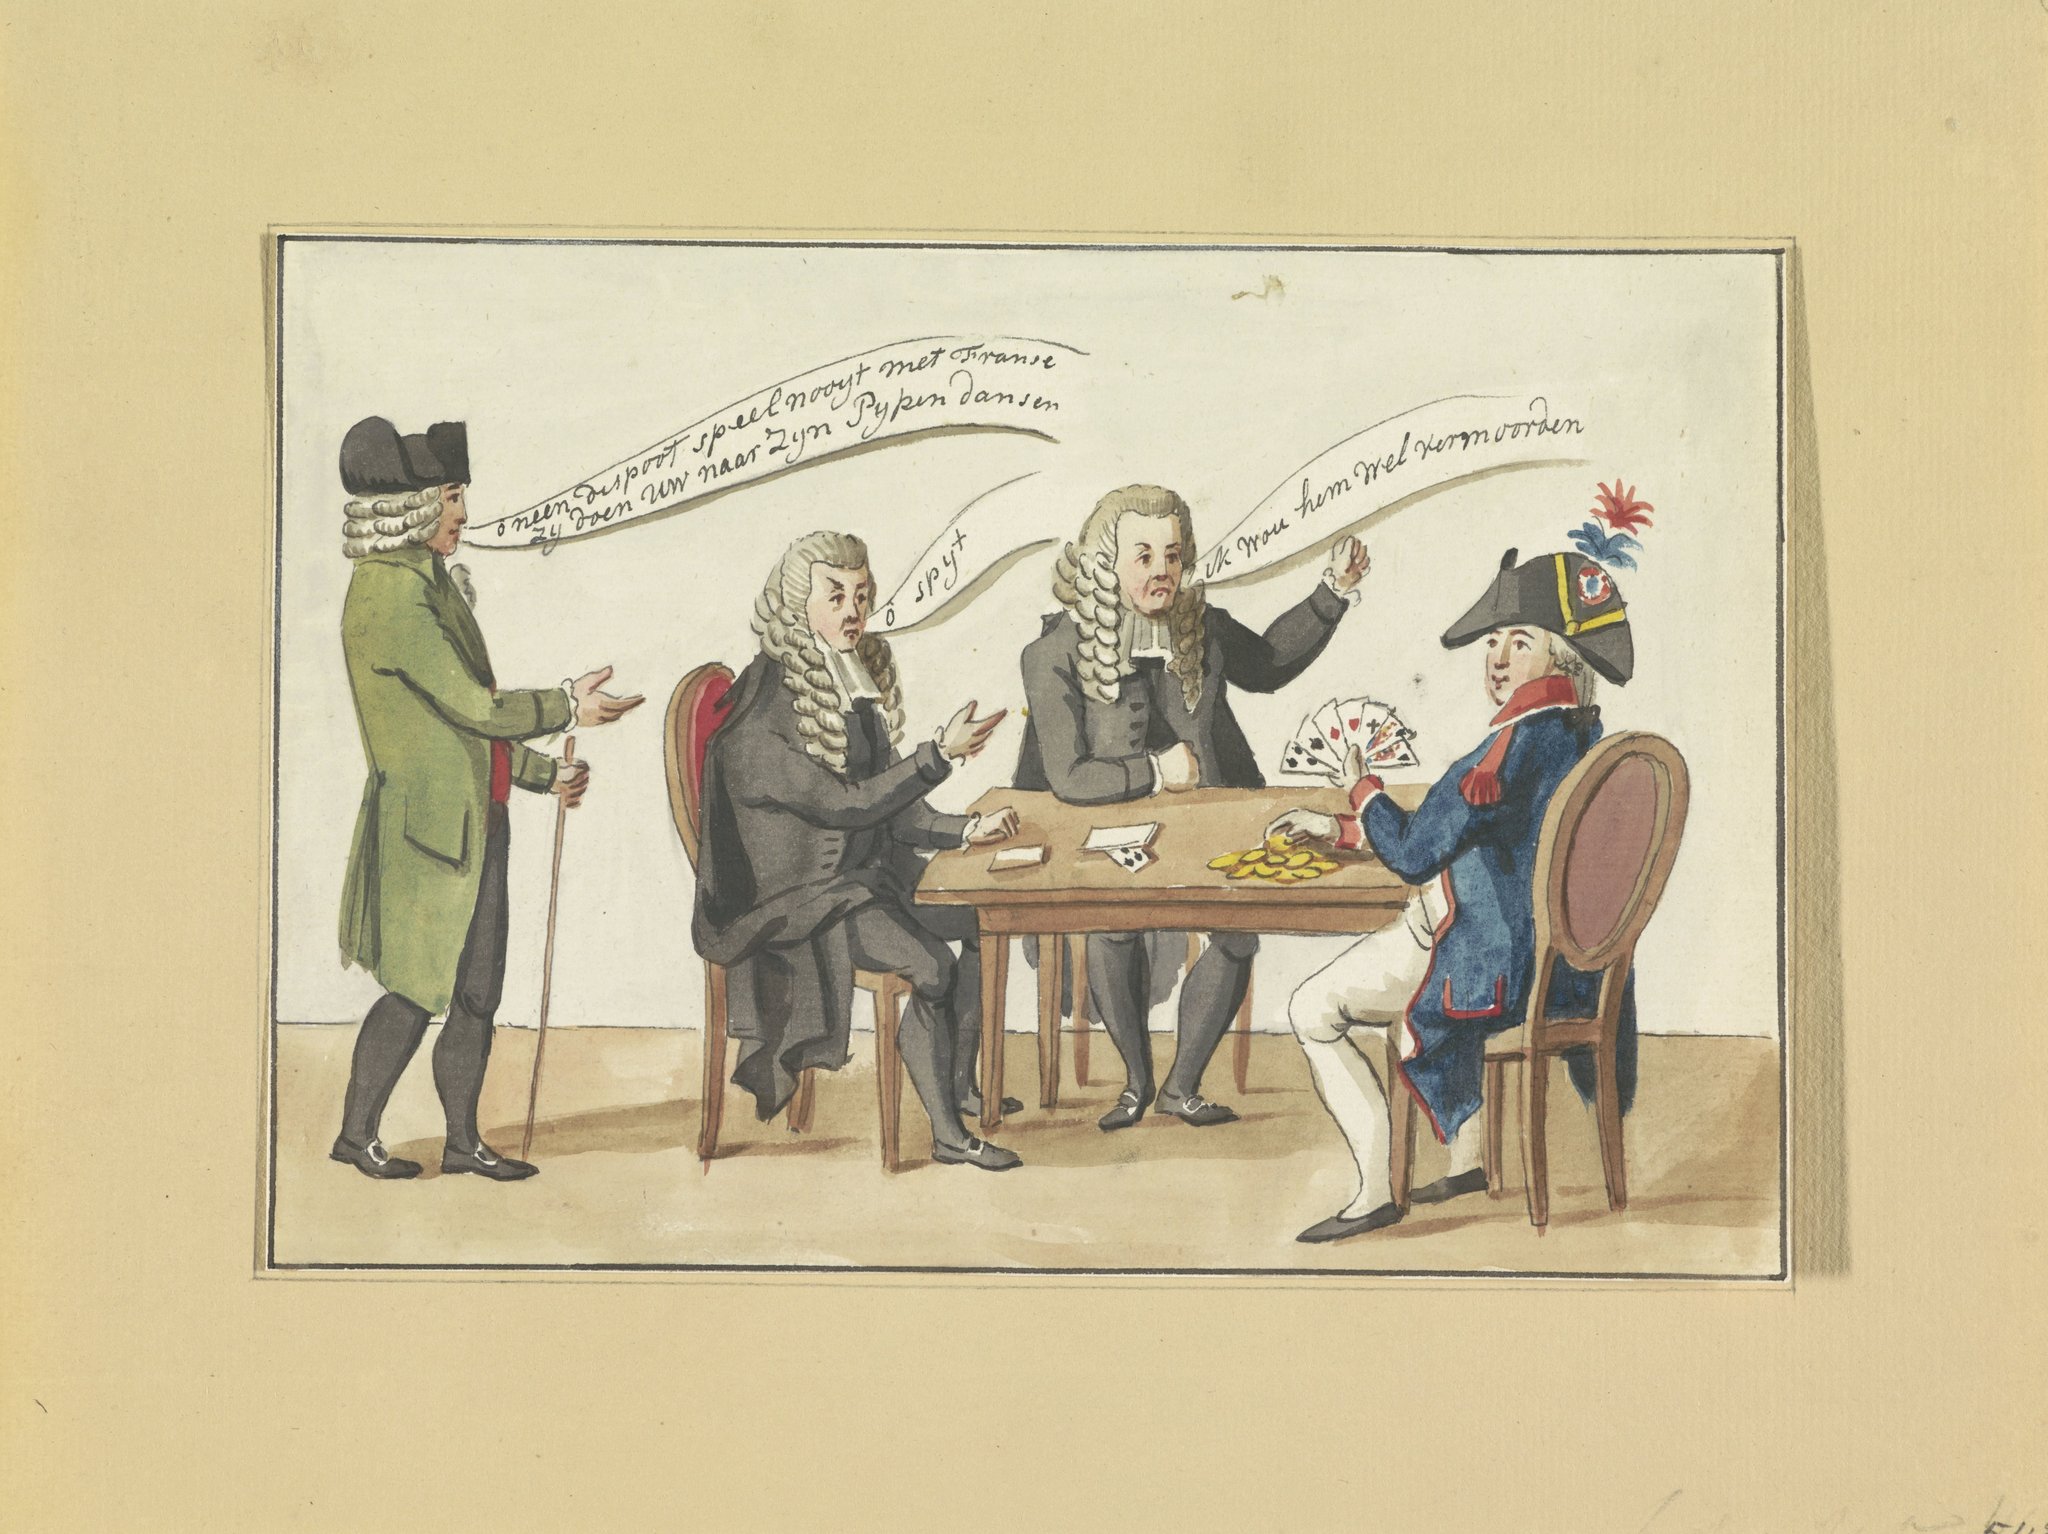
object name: drawing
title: Frankrijk wint het kaartspel, 1795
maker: Anonymous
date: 1795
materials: paper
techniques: brush, pen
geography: netherlands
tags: card games (+ quarrel, disagreement (in sports, games, etc.))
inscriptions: inscription: ‘D'aristocraat heeft groote spijt / Wijl hij 't omber spel is kwijt’, collector's mark: Lugt 2228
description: Twee aristocratische mannen met pruiken (burgemeesters of predikanten?) zittend aan een tafel verliezen het kaartspel van een Franse soldaat. Links waarschuwt een burger tegen het spelen met de Fransen.